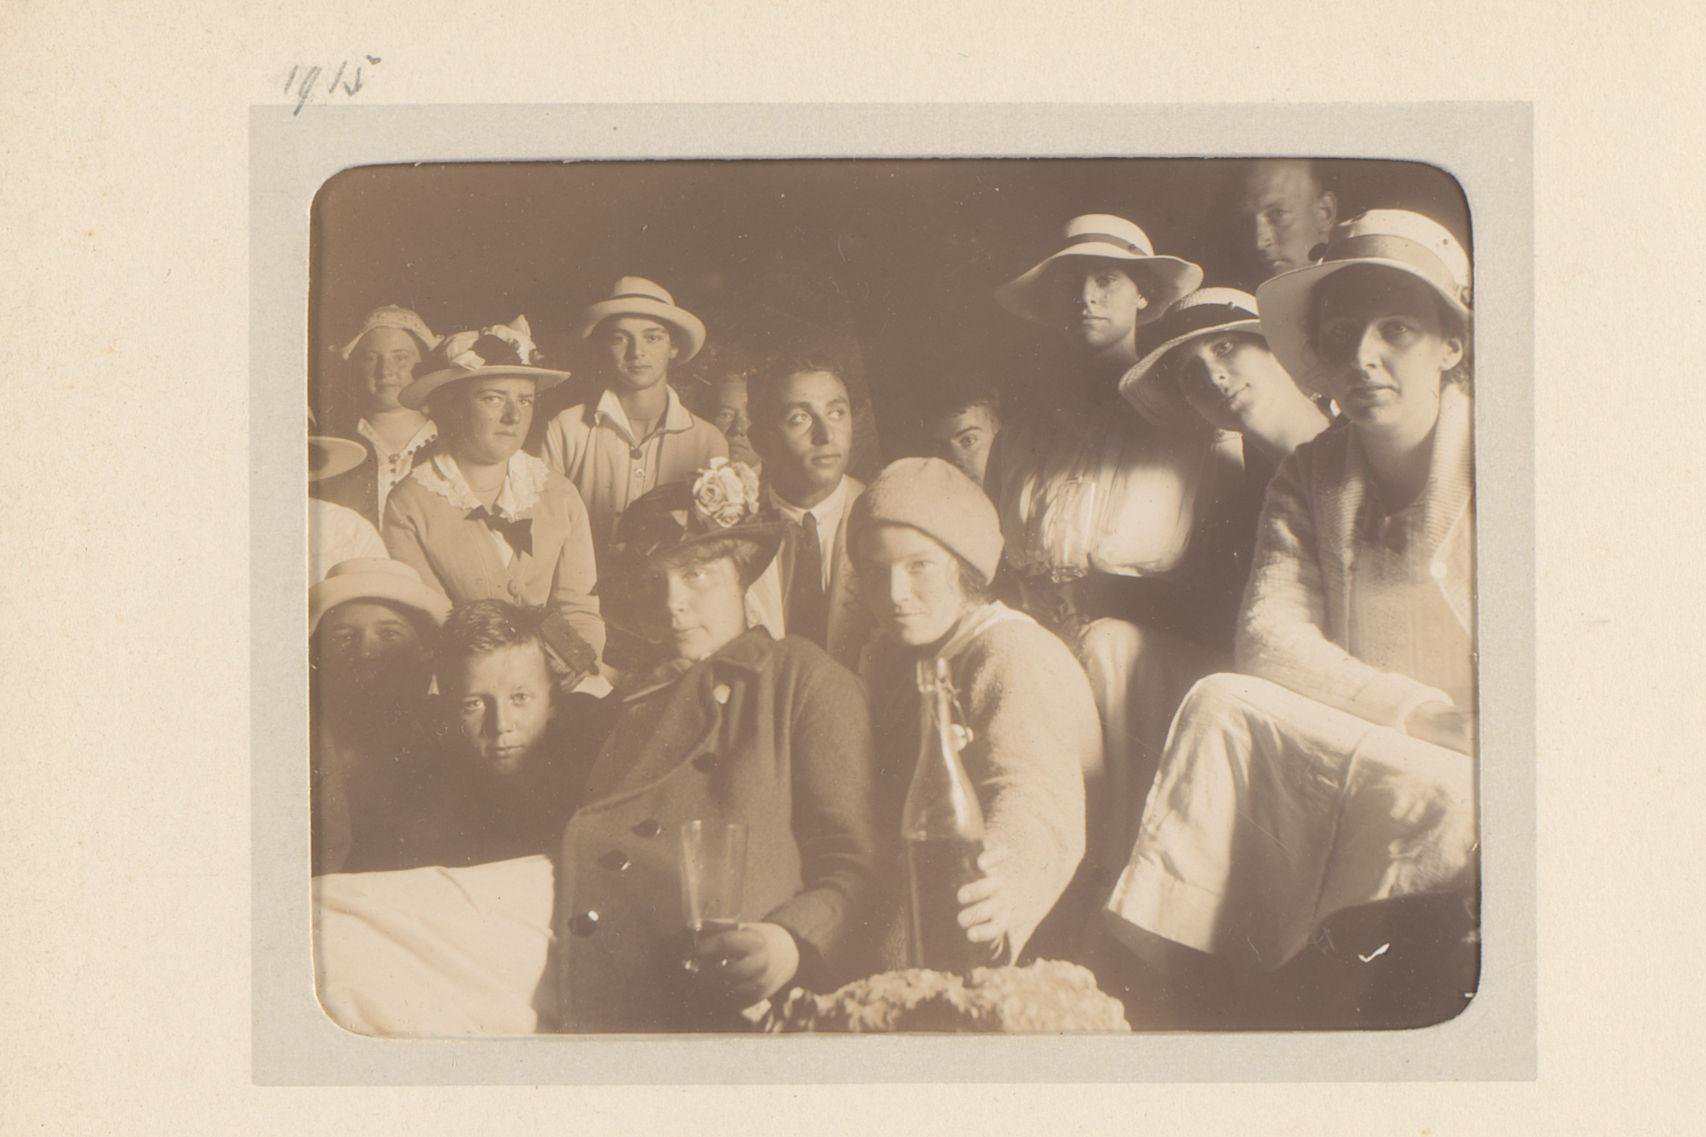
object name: photograph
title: Groepsportret van een gezelschap, enkelen hebben een glas of fles in de hand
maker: liesbeth overhoff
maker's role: fotograaf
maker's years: 1895-1969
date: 1915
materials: paper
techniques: gelatin silver print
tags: historical persons, container of glass: bottle, jar, vase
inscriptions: inscription: ‘1915’